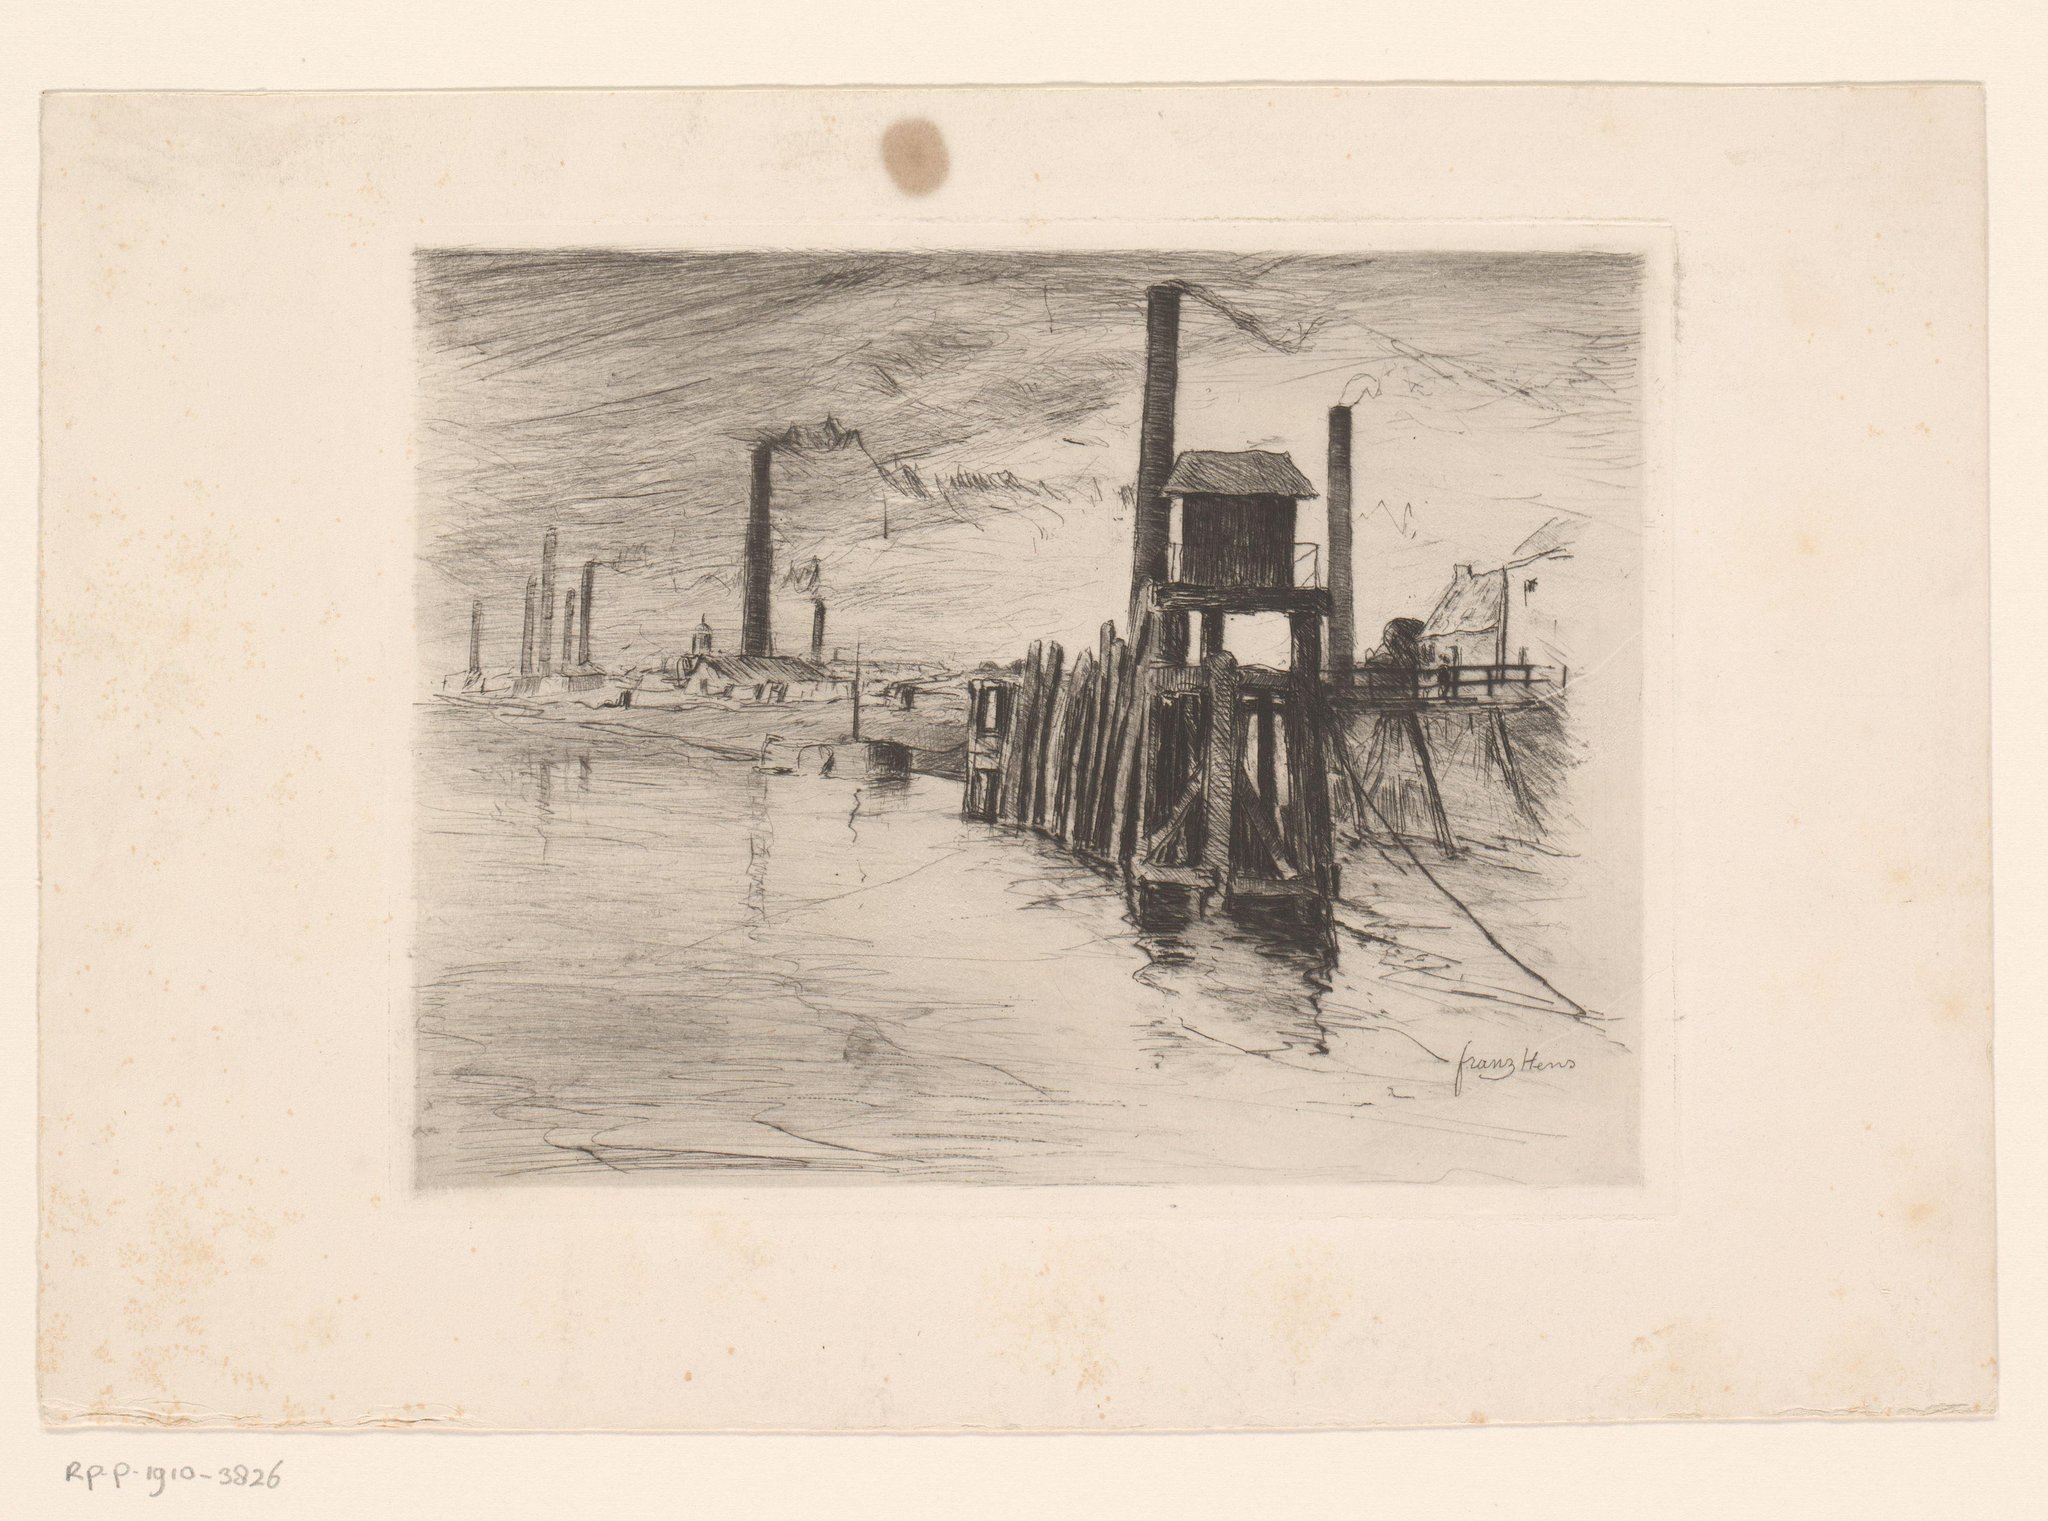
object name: print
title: Industriële haven met schoorstenen en een toren in het water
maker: frans hens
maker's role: print maker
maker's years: 1856-1928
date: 1866-1910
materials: paper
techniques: drypoint, etching, intaglio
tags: harbour, chimney, industries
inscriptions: collector's mark: Lugt 2228